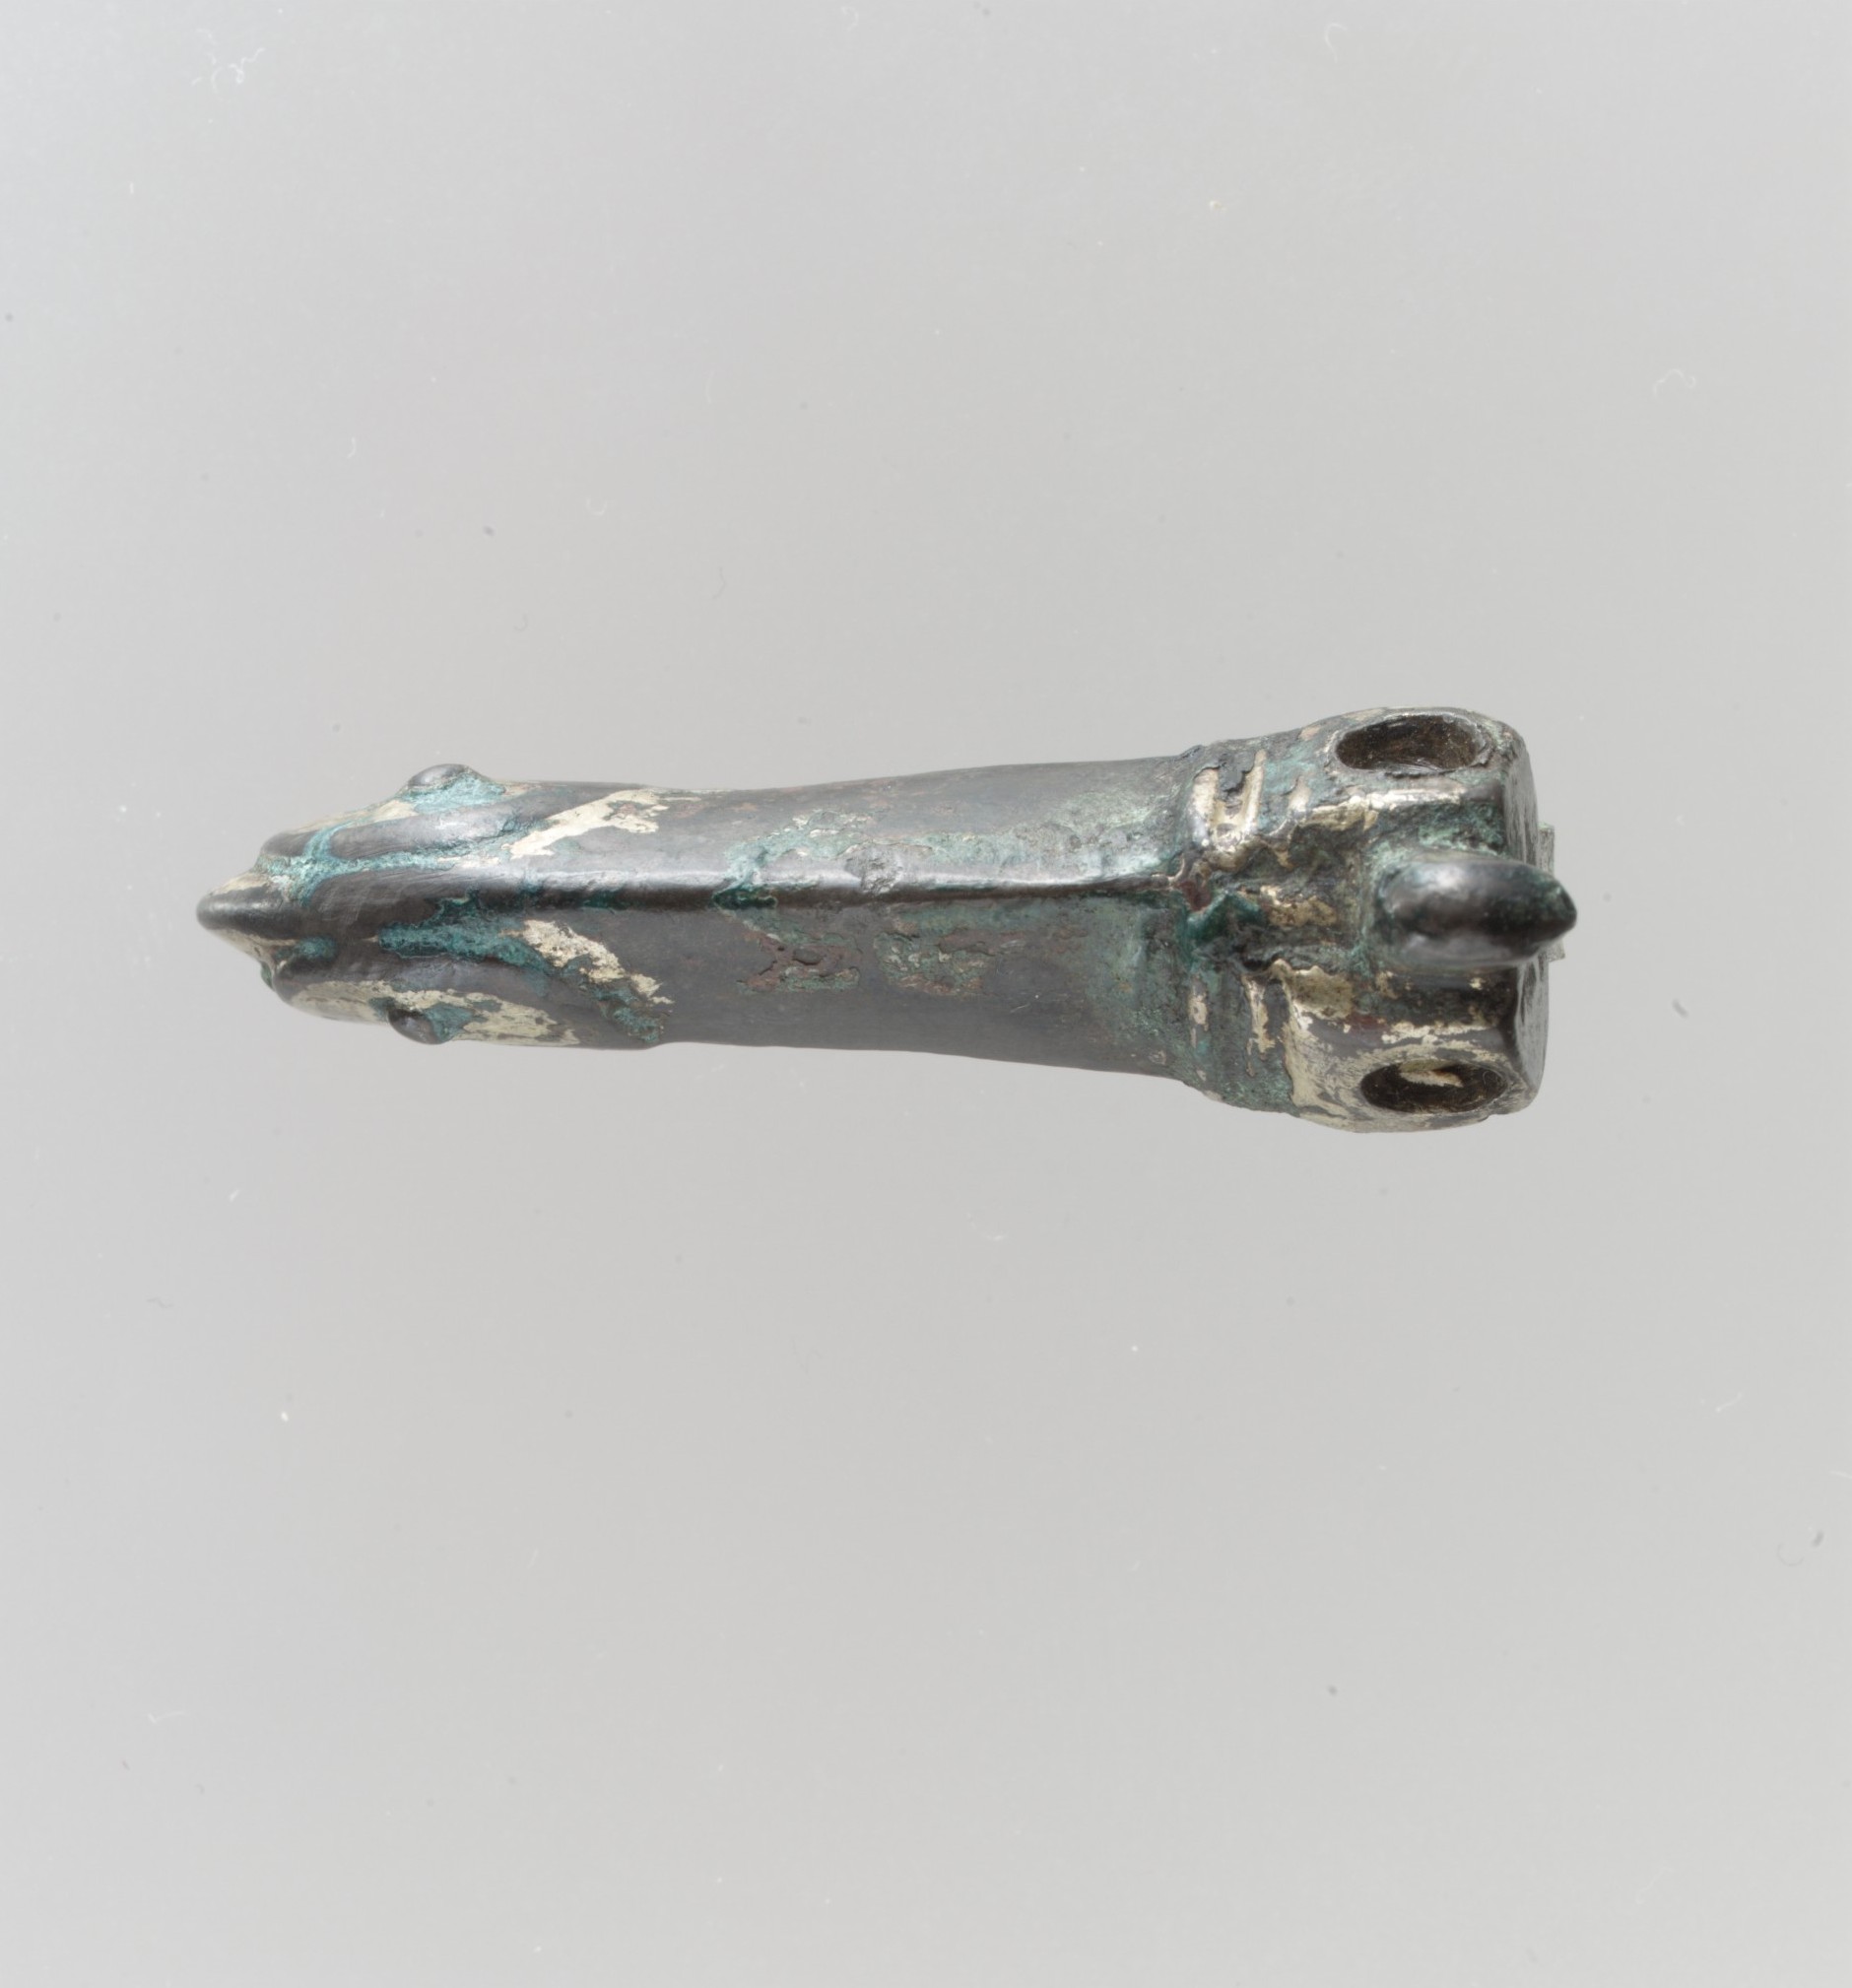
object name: buckle tongue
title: Tongue from a buckle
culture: ostrogothic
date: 501-700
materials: silver gilt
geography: black sea